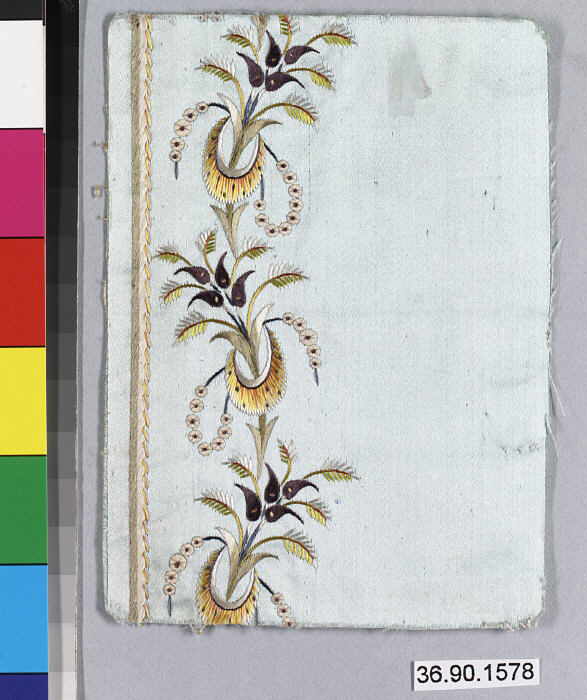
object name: sample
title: Embroidery sample for a man’s suit or waistcoat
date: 1785-1815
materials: silk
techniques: embroidery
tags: flowers